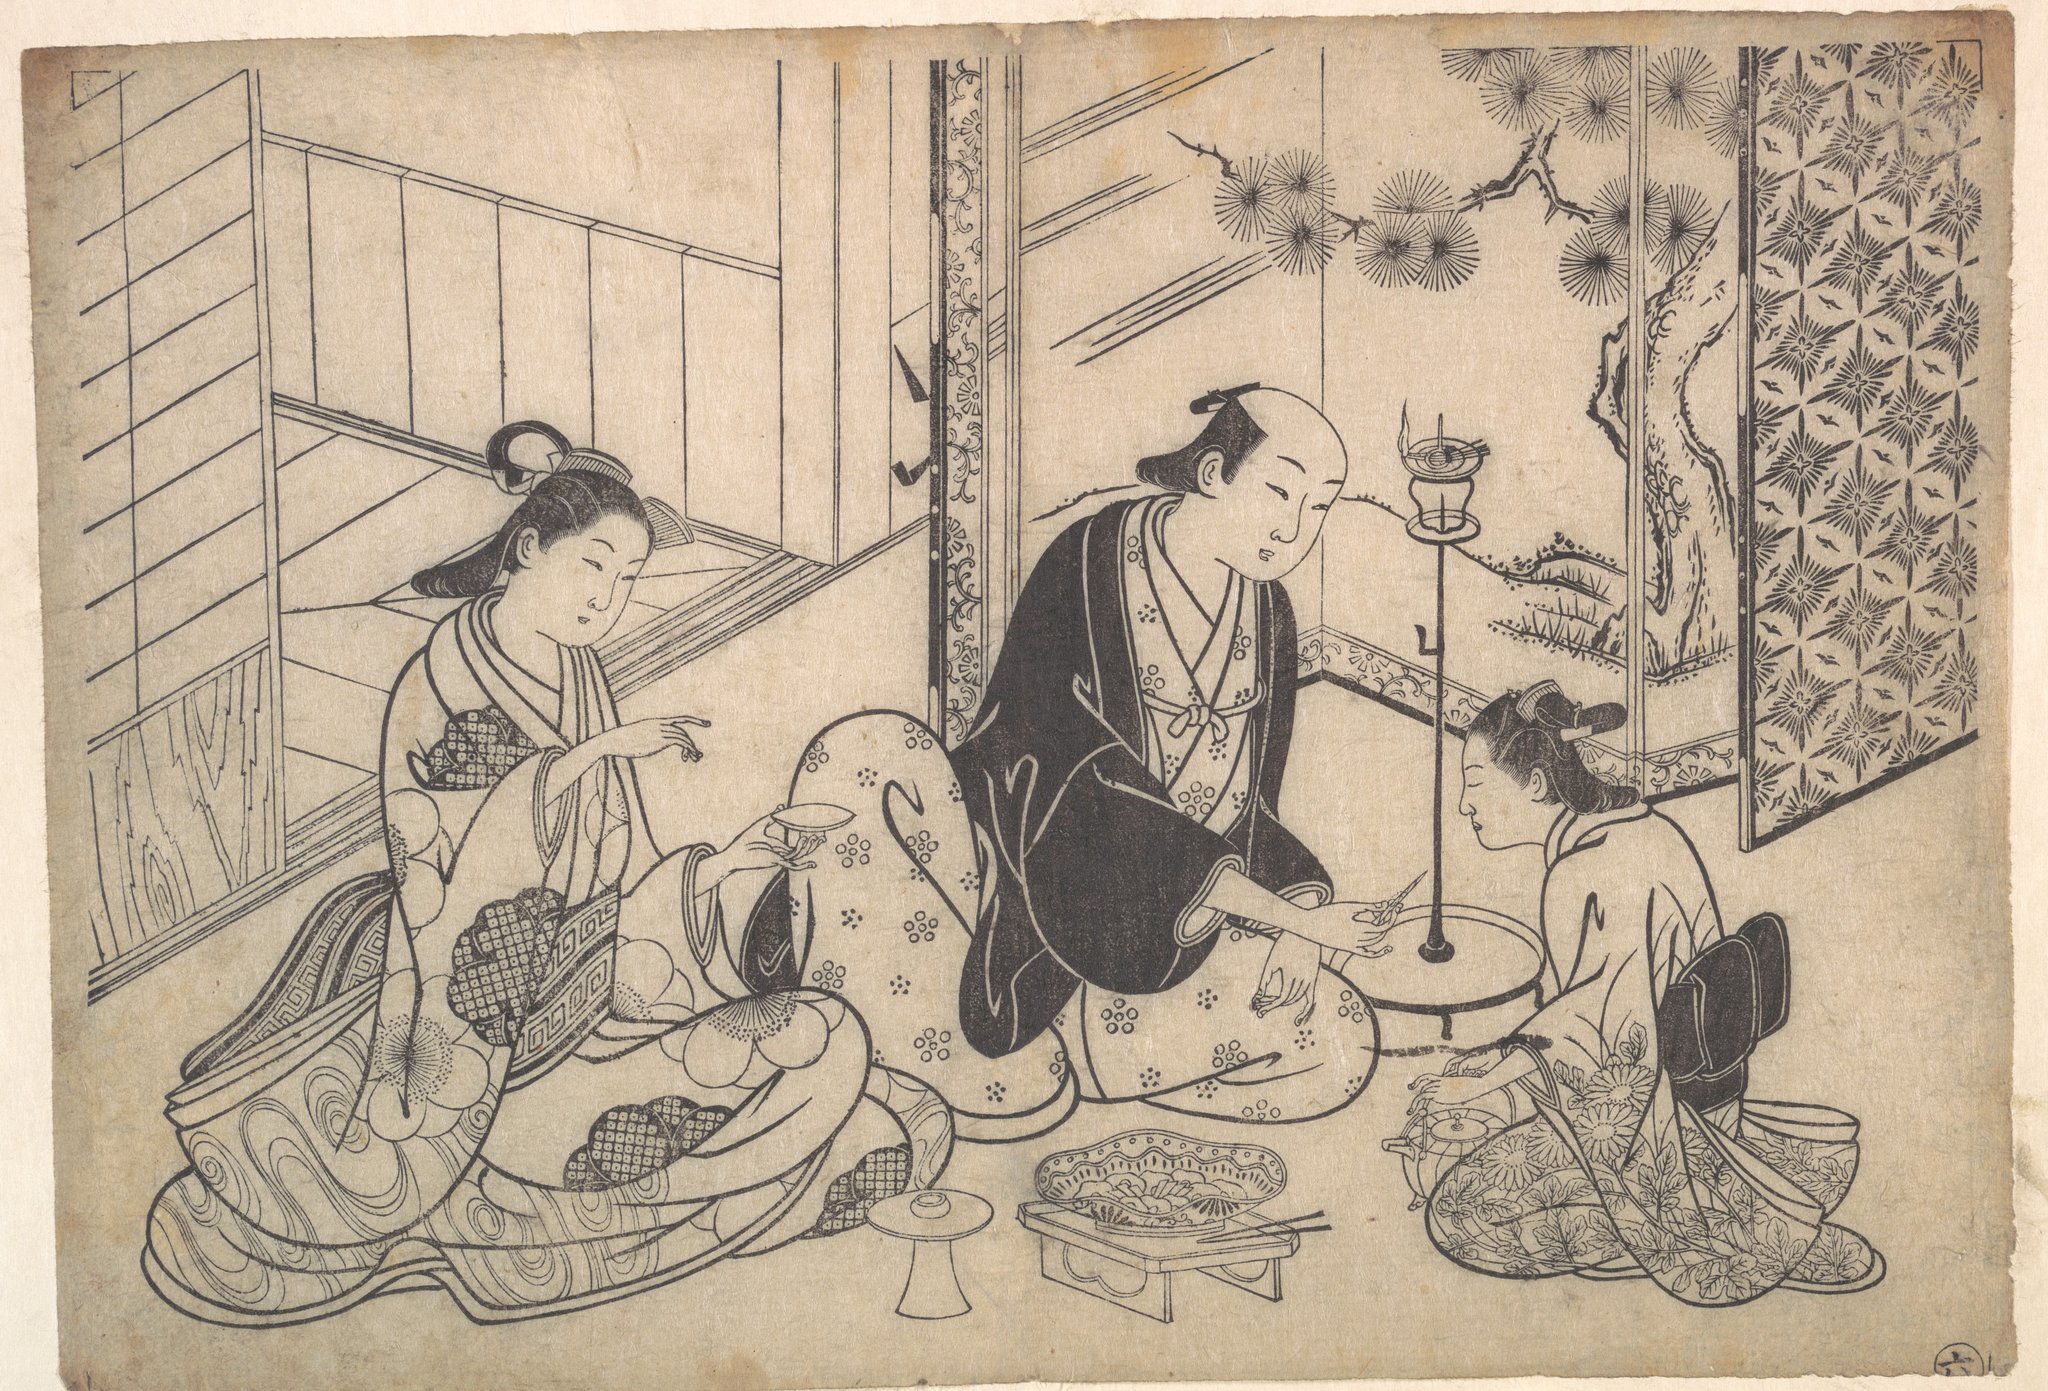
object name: print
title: Interior, Three Figures: Sake Party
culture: japanese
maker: hasegawa mitsunobu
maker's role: artist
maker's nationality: japanese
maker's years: 1724-1754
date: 1730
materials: ink, paper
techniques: woodblock print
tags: interiors,men,women,drinking